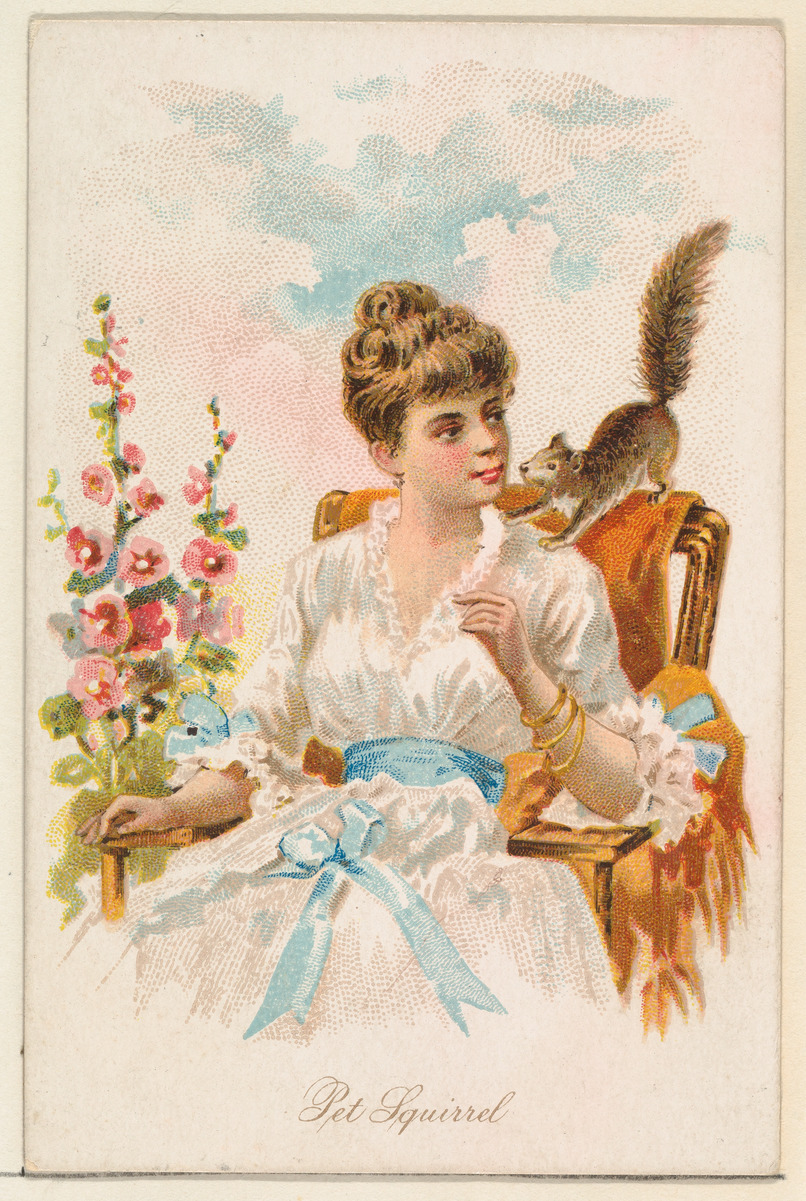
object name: print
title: Pet Squirrel, from the Household Pets series (N194) issued by Wm. S. Kimball & Co.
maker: william s. kimball & company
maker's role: publisher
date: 1891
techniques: color lithograph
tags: women,squirrels